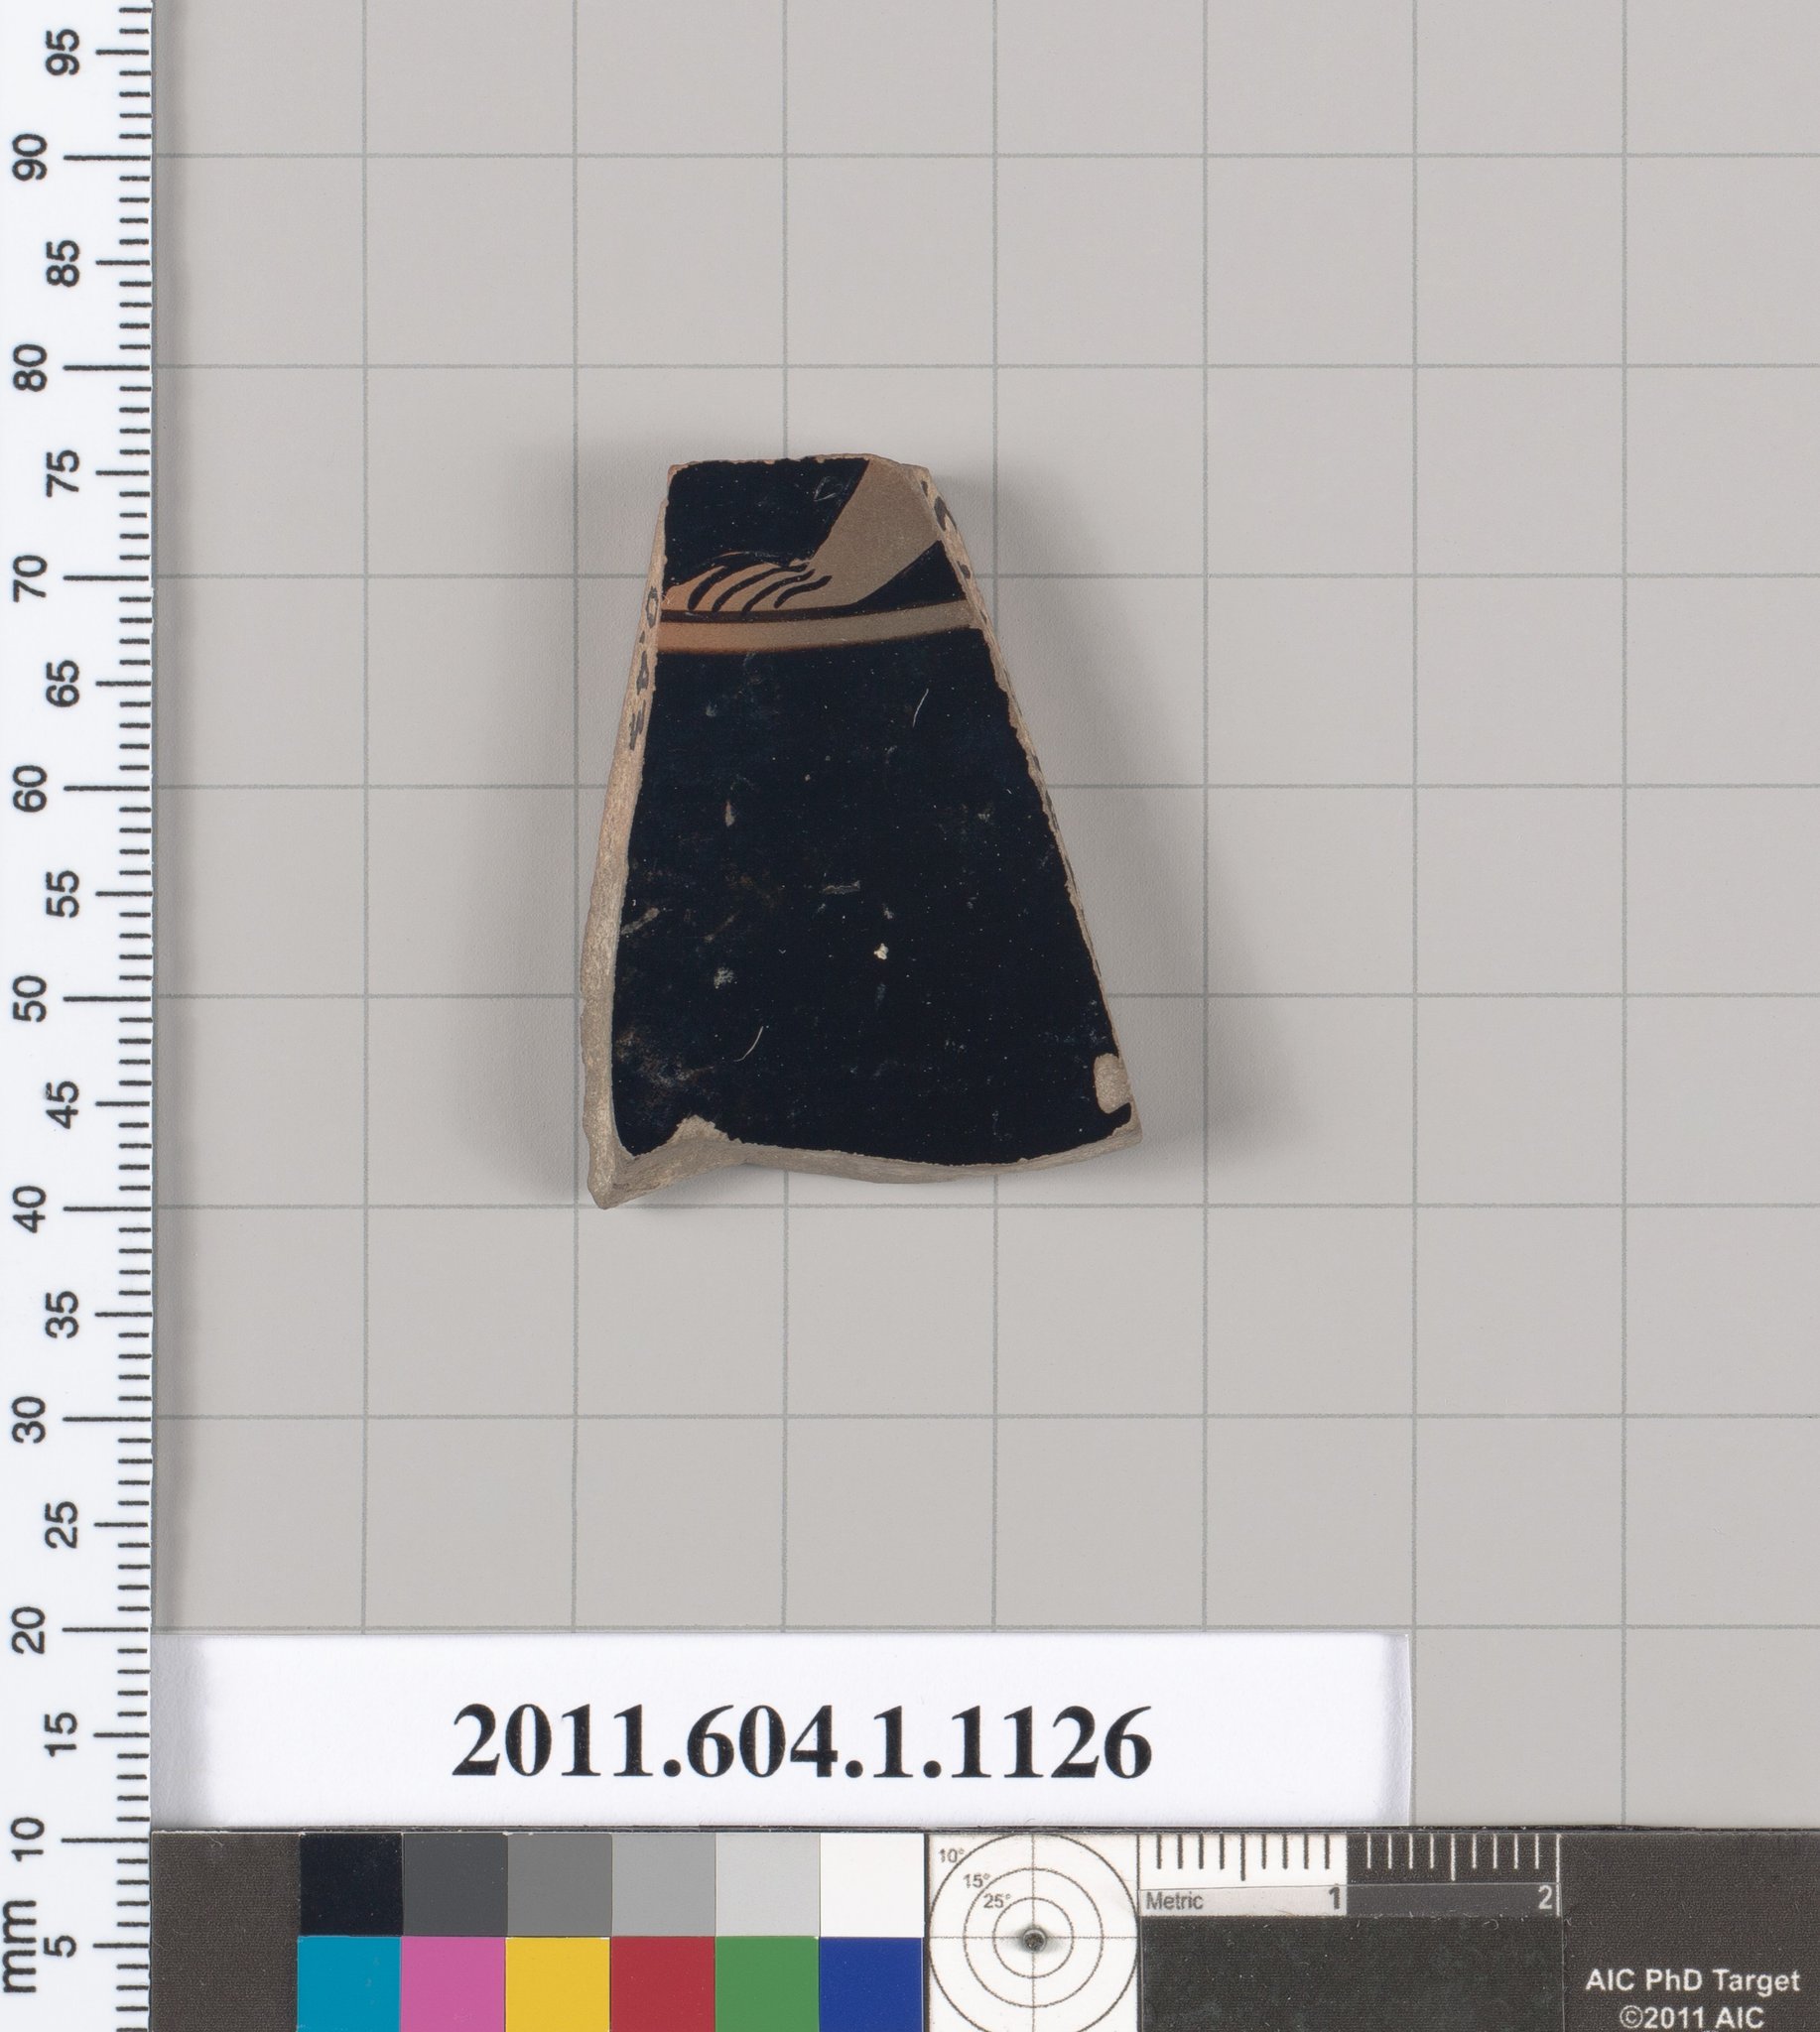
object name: kylix fragment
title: Terracotta fragment of a kylix (drinking cup)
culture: greek, attic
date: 490-480 BCE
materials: terracotta